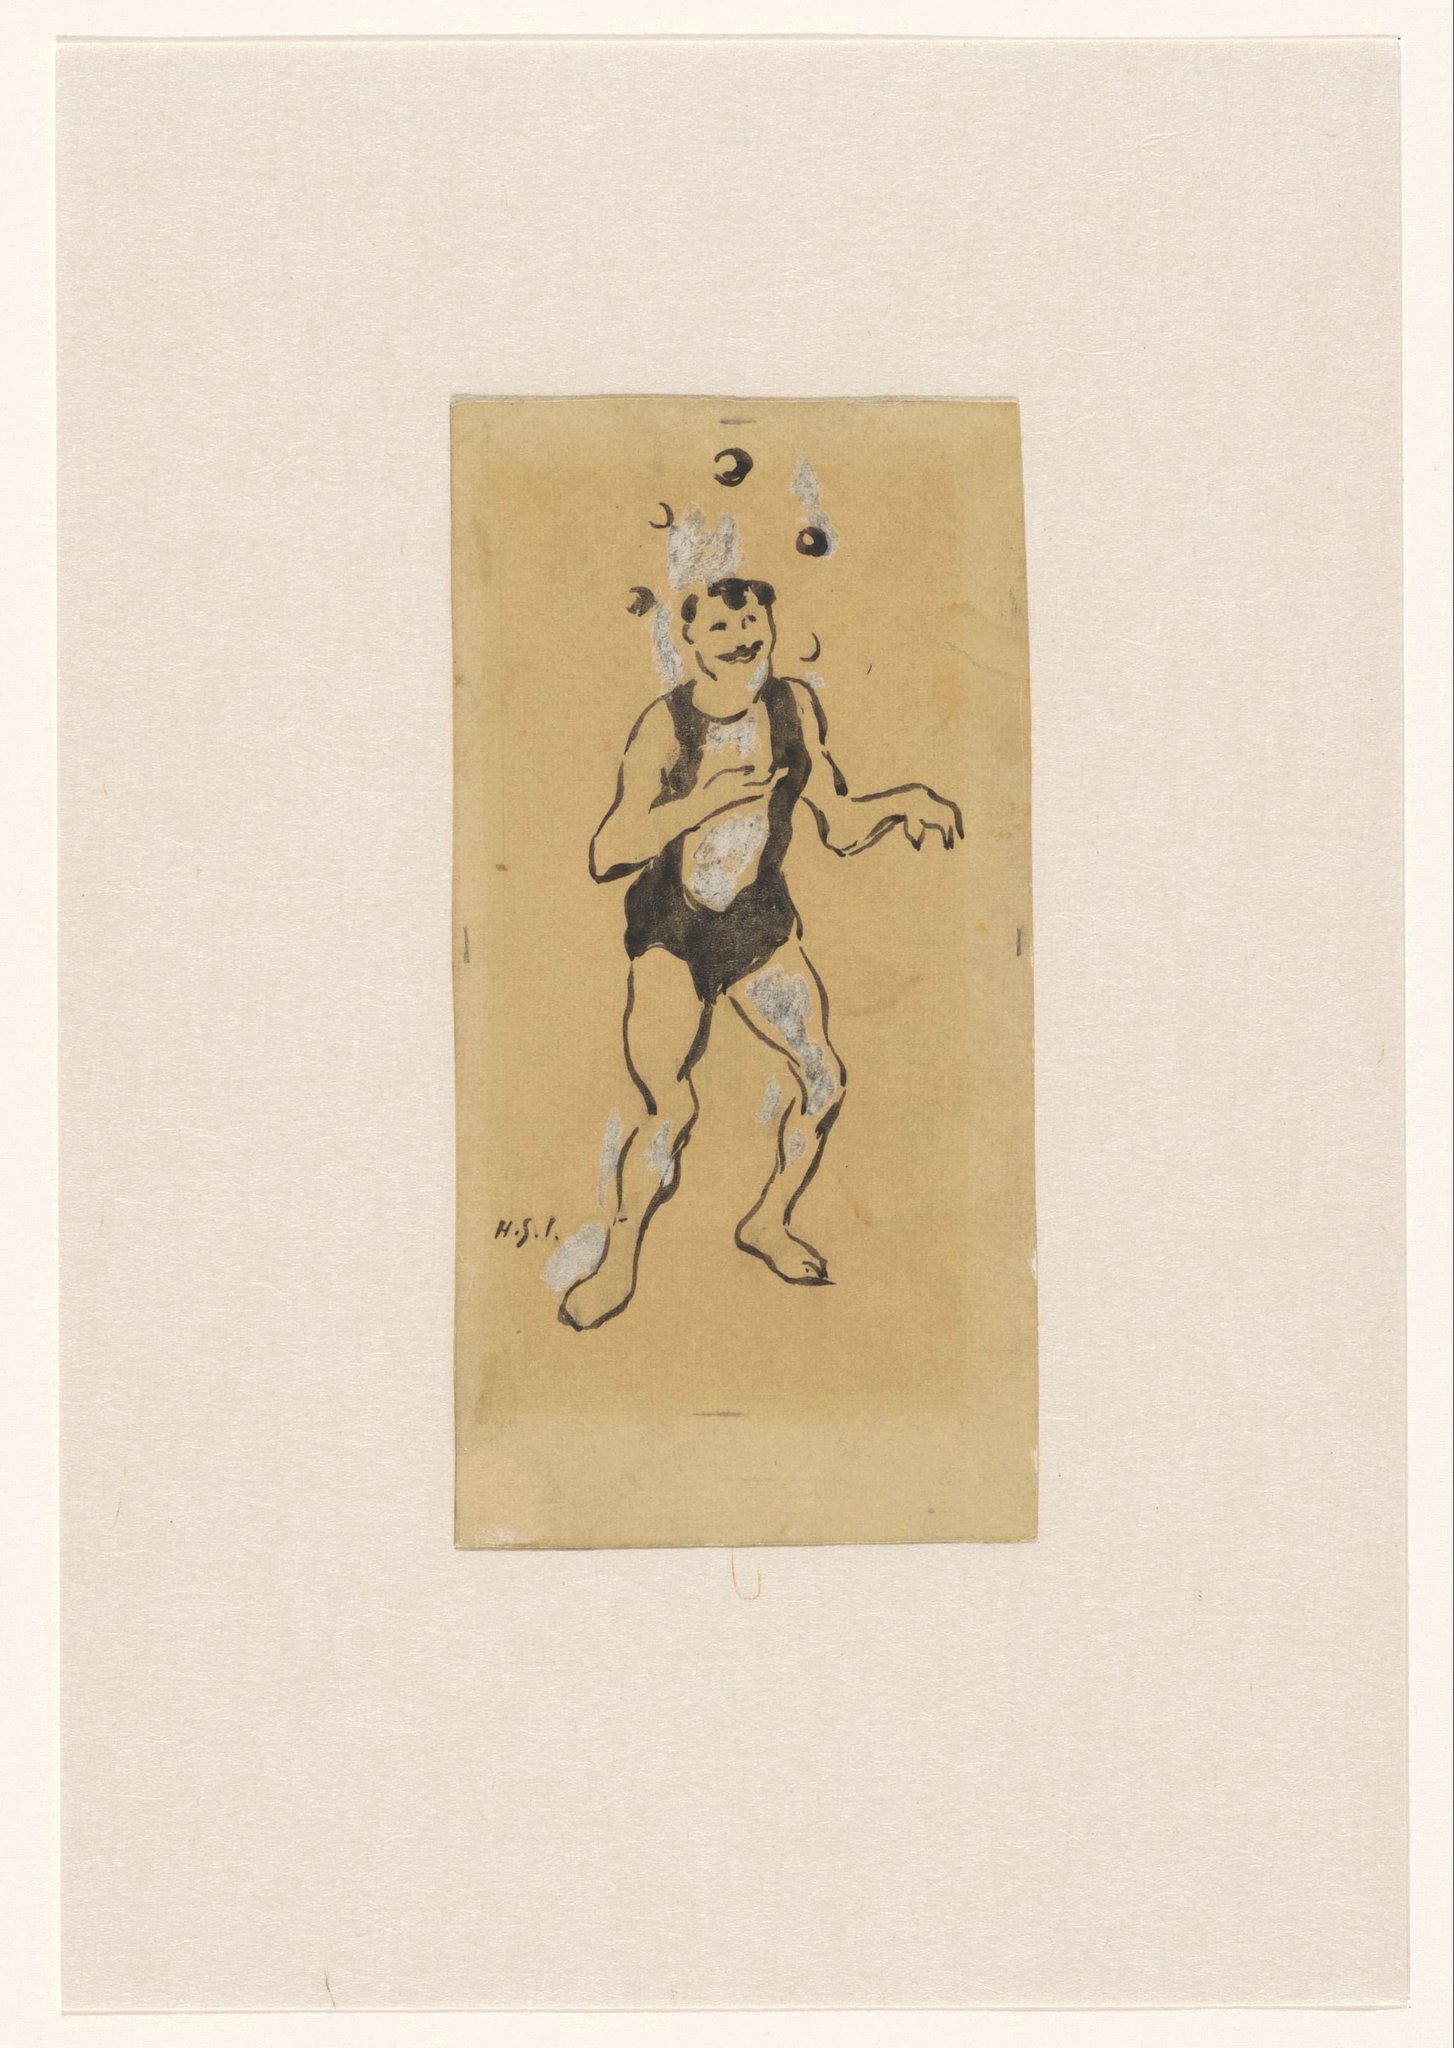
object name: drawing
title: Jongleur met ballen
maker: henri gabriel ibels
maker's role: print maker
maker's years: 1867-1936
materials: paint, paper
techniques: brush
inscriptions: monogram: ‘H.G.I.’